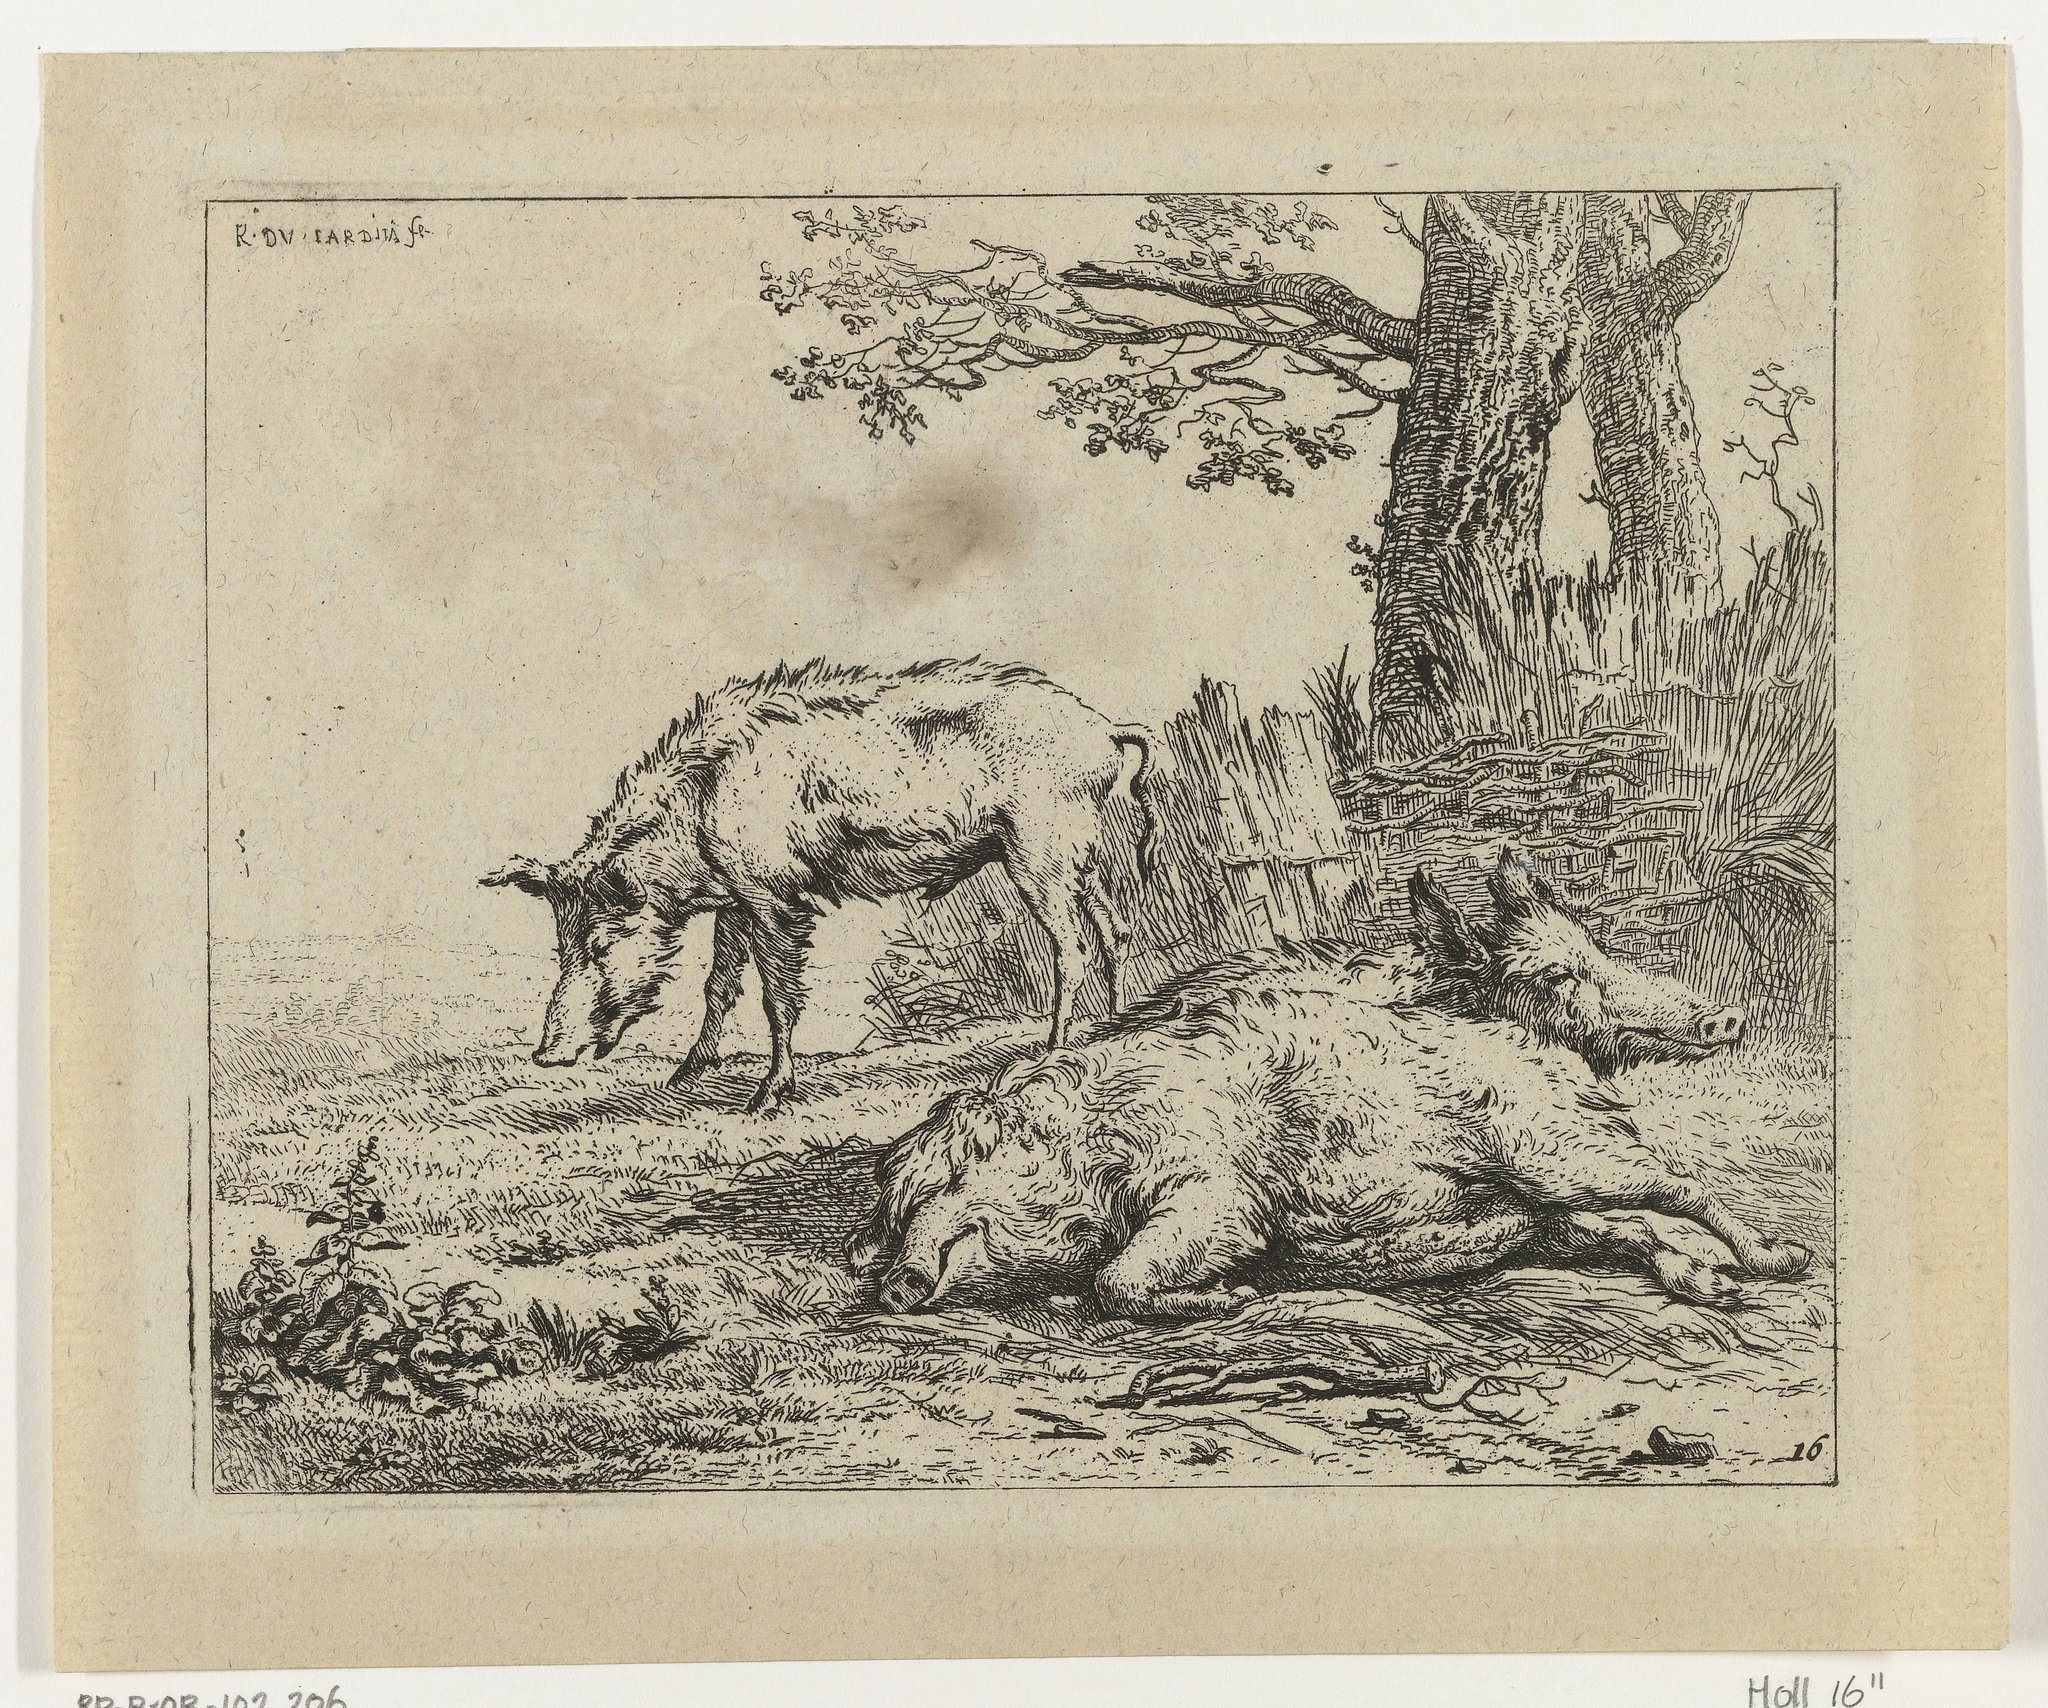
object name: print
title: Drie zwijnen bij een heg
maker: karel du jardin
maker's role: draughtsman, painter, print maker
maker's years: 1626-1678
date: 1656-1658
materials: paper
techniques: etching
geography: the hague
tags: hoofed animals: boar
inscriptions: collector's mark: Lugt 2228